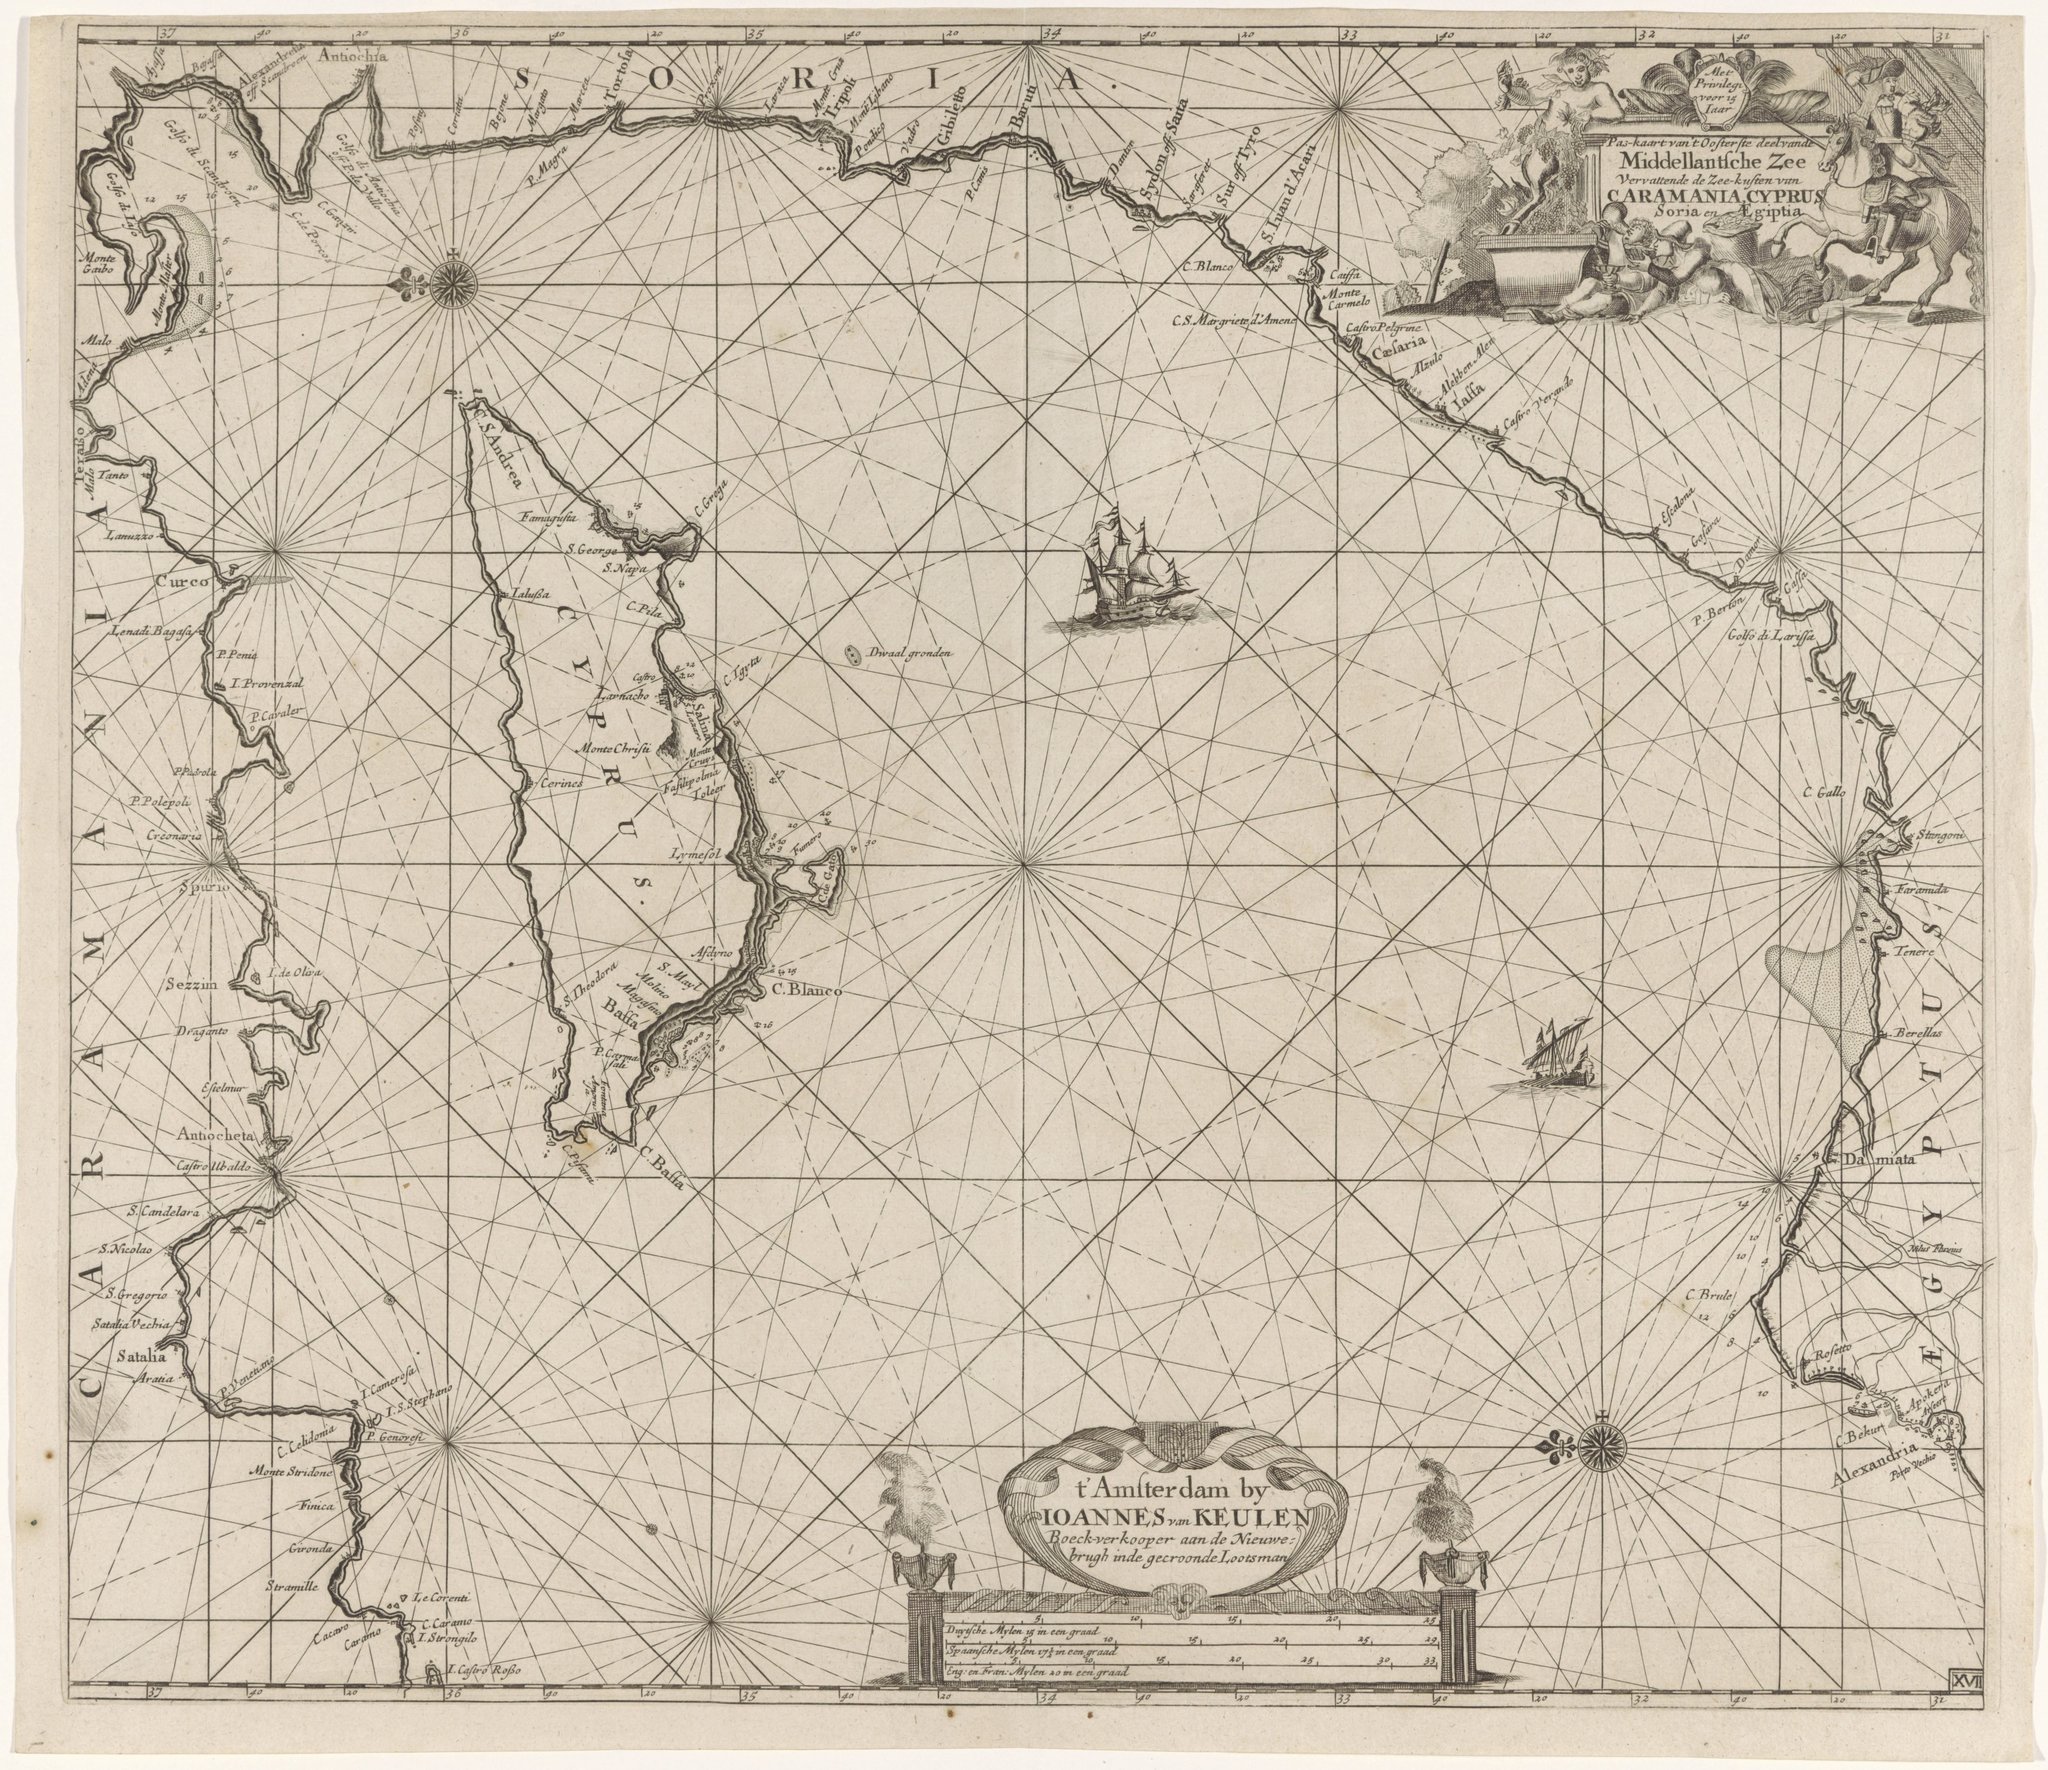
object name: print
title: Paskaart van het oostelijk deel van de Middellandse Zee, met Cyprus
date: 1682-1803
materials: paper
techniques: engraving, etching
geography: amsterdam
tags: riding a horse, ass, or mule; rider, horseman, sailing-ship, sailing-boat, satyrs, fauns, sileni, drinking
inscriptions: collector's mark: Lugt 2228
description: Paskaart van het oostelijk deel van de Middellandse Zee, met Cyprus, en twee kompasrozen, het Noorden ligt links. Rechtsboven de titel, waarbij een ruiter, een jonge faun en twee drinkende figuren. Middenonder het uigeversadres en de schaalverdeling, weergegeven in Duitse, Spaanse en Engelse of Franse mijlen (schaal: c. 1:1.200.000).